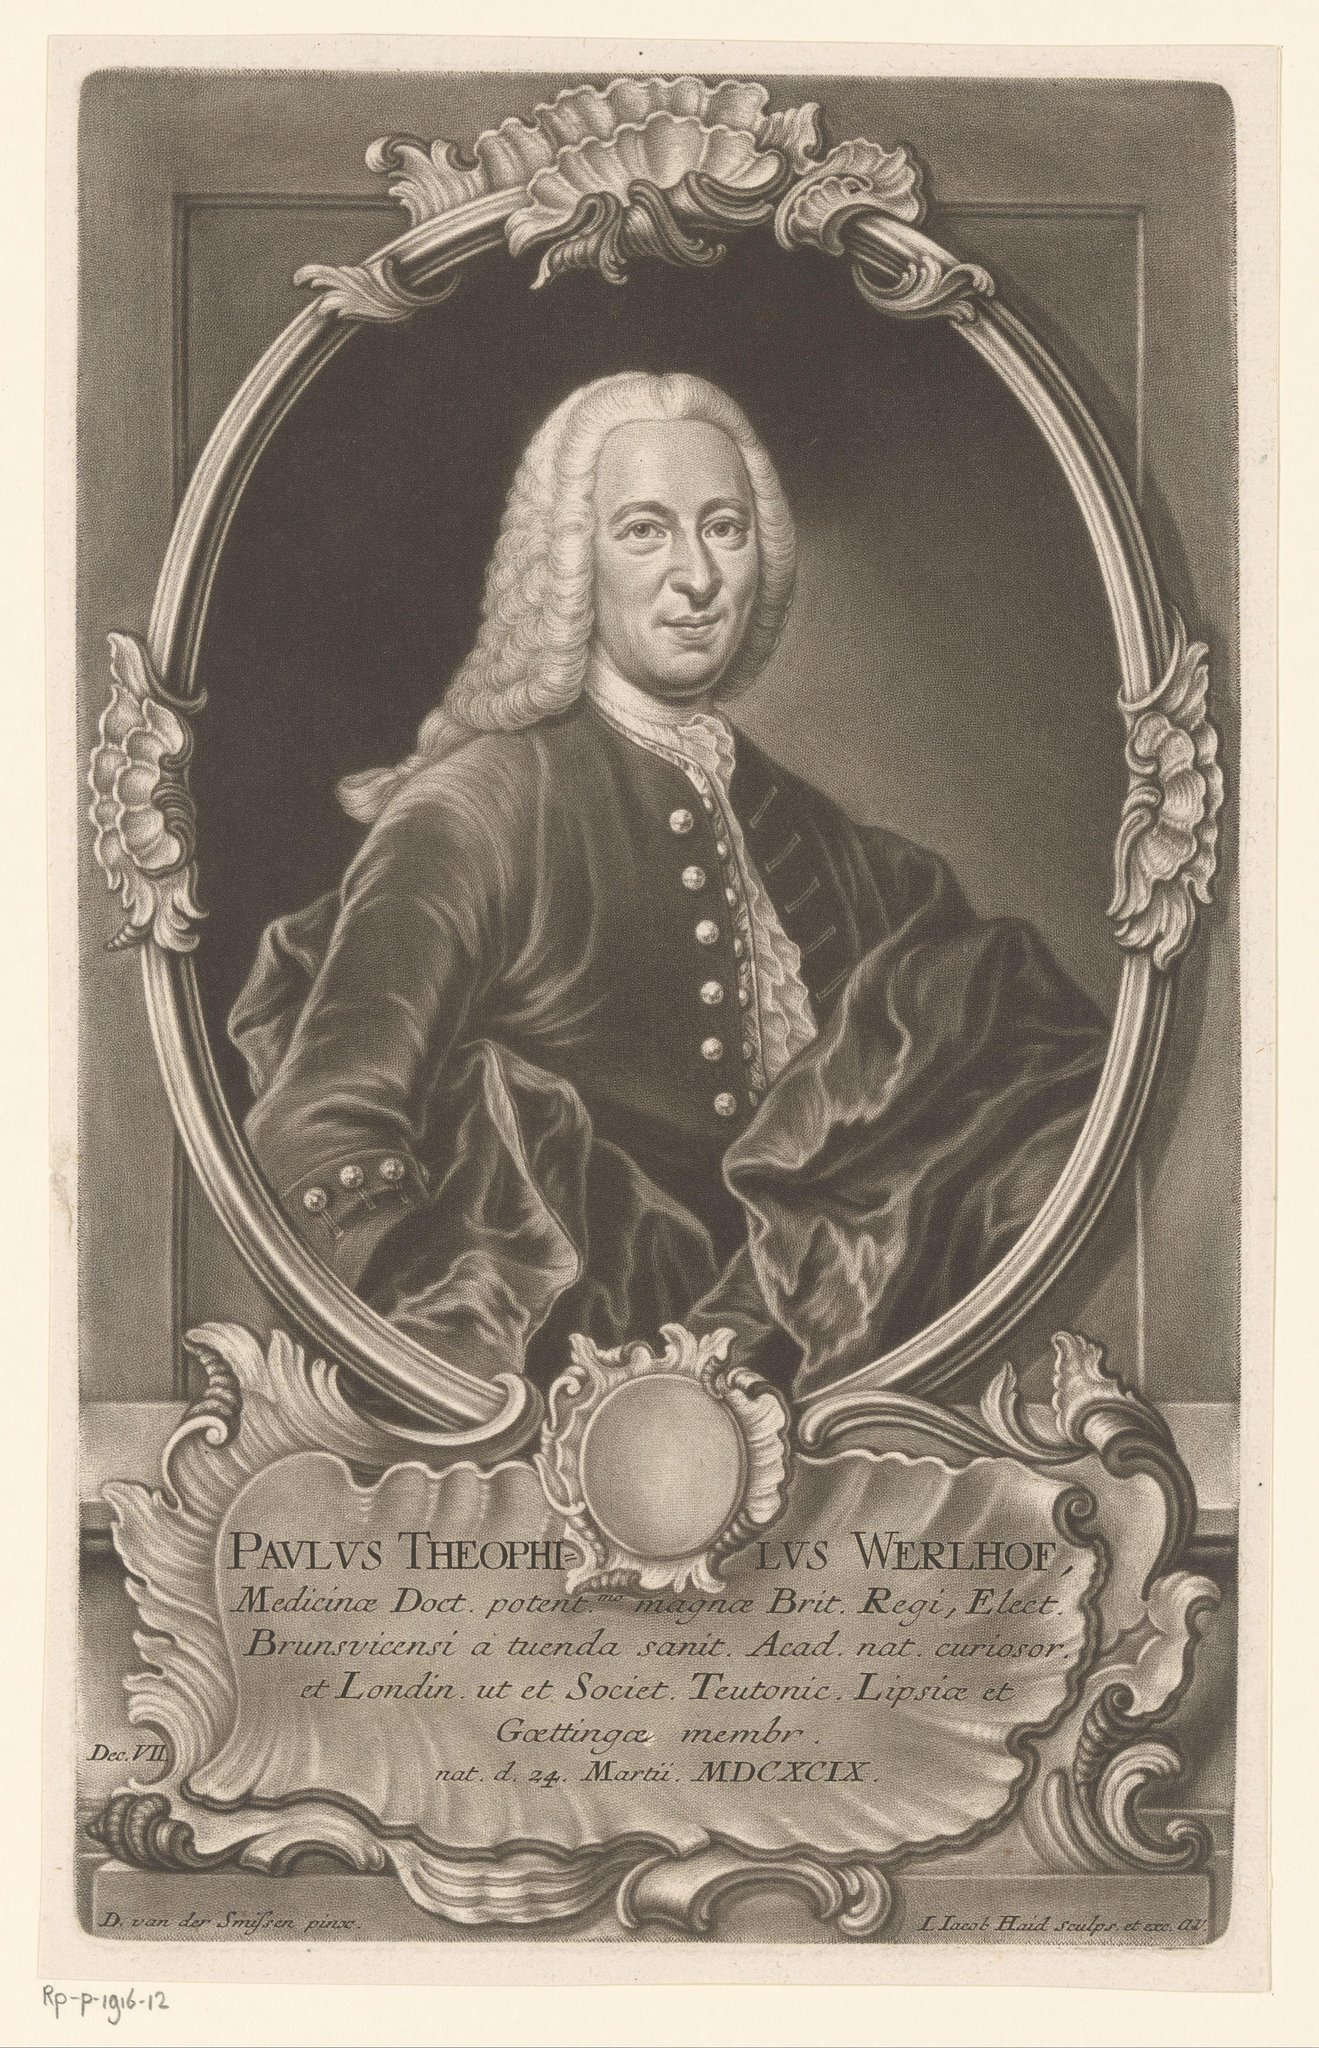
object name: print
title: Portret van Paul Gottlieb Werlhof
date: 1748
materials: paper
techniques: mezzotint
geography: augsburg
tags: paul gottlieb werlhof, rocaille ornament, historical persons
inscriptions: collector's mark: Lugt 2228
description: Latere staat van deze prent gebruikt voor: Brucker, Jacob. Bildersal heutiges Tages lebender und durch Gelahrheit berühmter Schrifftsteller. Augsburg: Johann Jacob Haid, 1748.